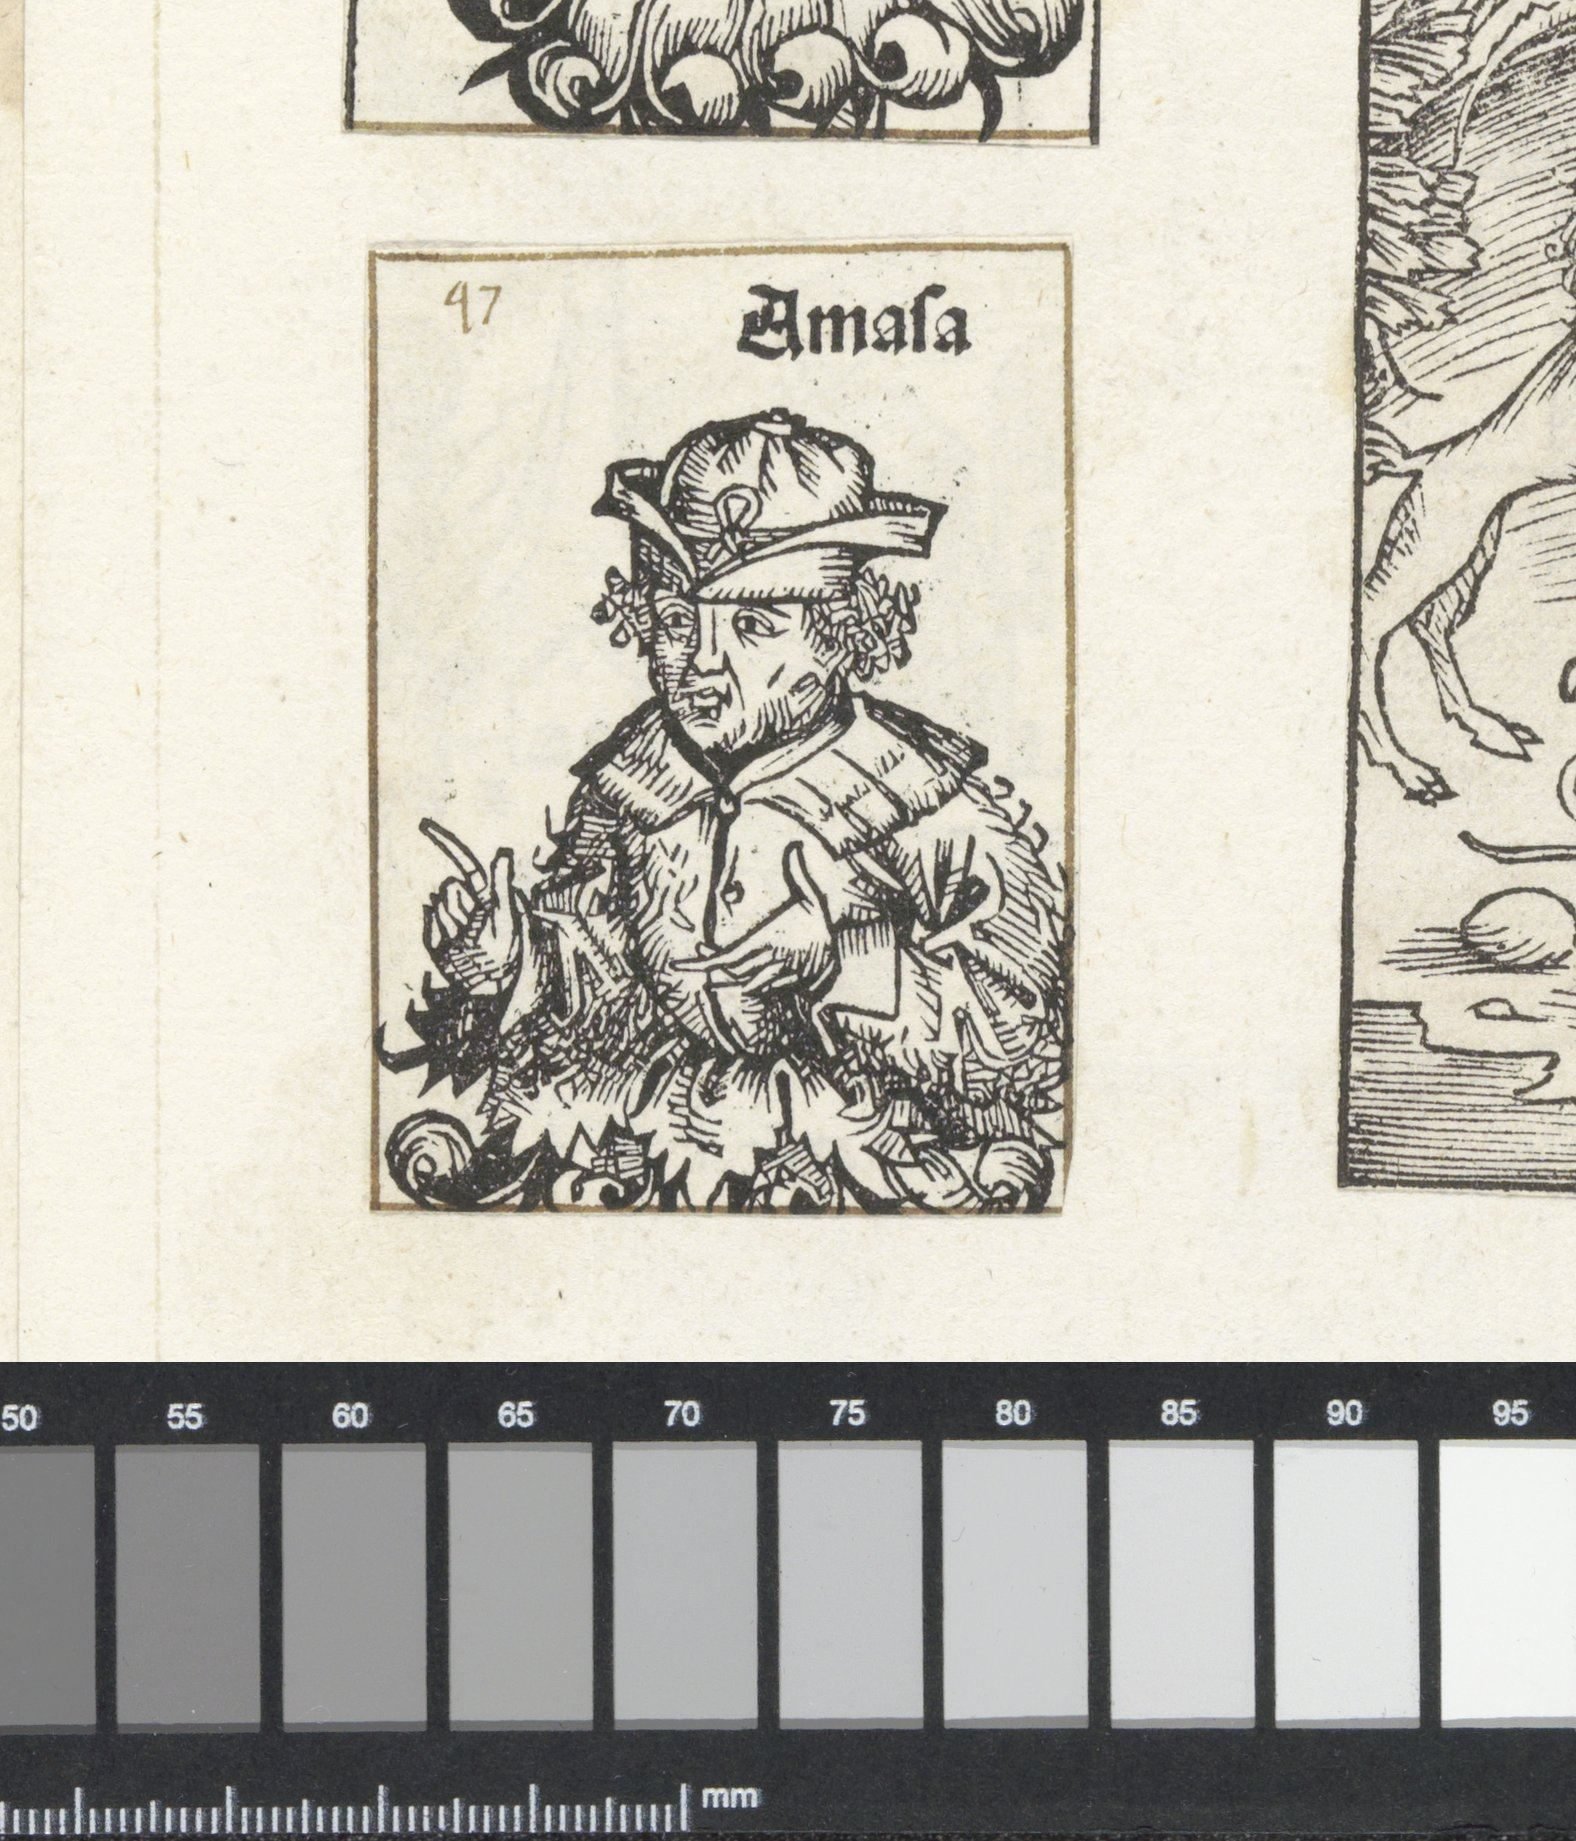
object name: print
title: Liber Chronicarum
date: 1493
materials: paper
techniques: letterpress printing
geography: nuremberg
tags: persons from the old testament (not in biblical context, nor occurring in legendary/historical extensions included in division 71)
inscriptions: inscription: ‘47’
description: Een bloemkelk met een man, naar links gekeerd en met een hoed. De tekst identificeert hem als Amasa, de zoon van Jeter en Abigail. De voorstelling is een fragment van de stamboom van Christus in de Liber Chronicarum. De prent maakt deel uit van een album.